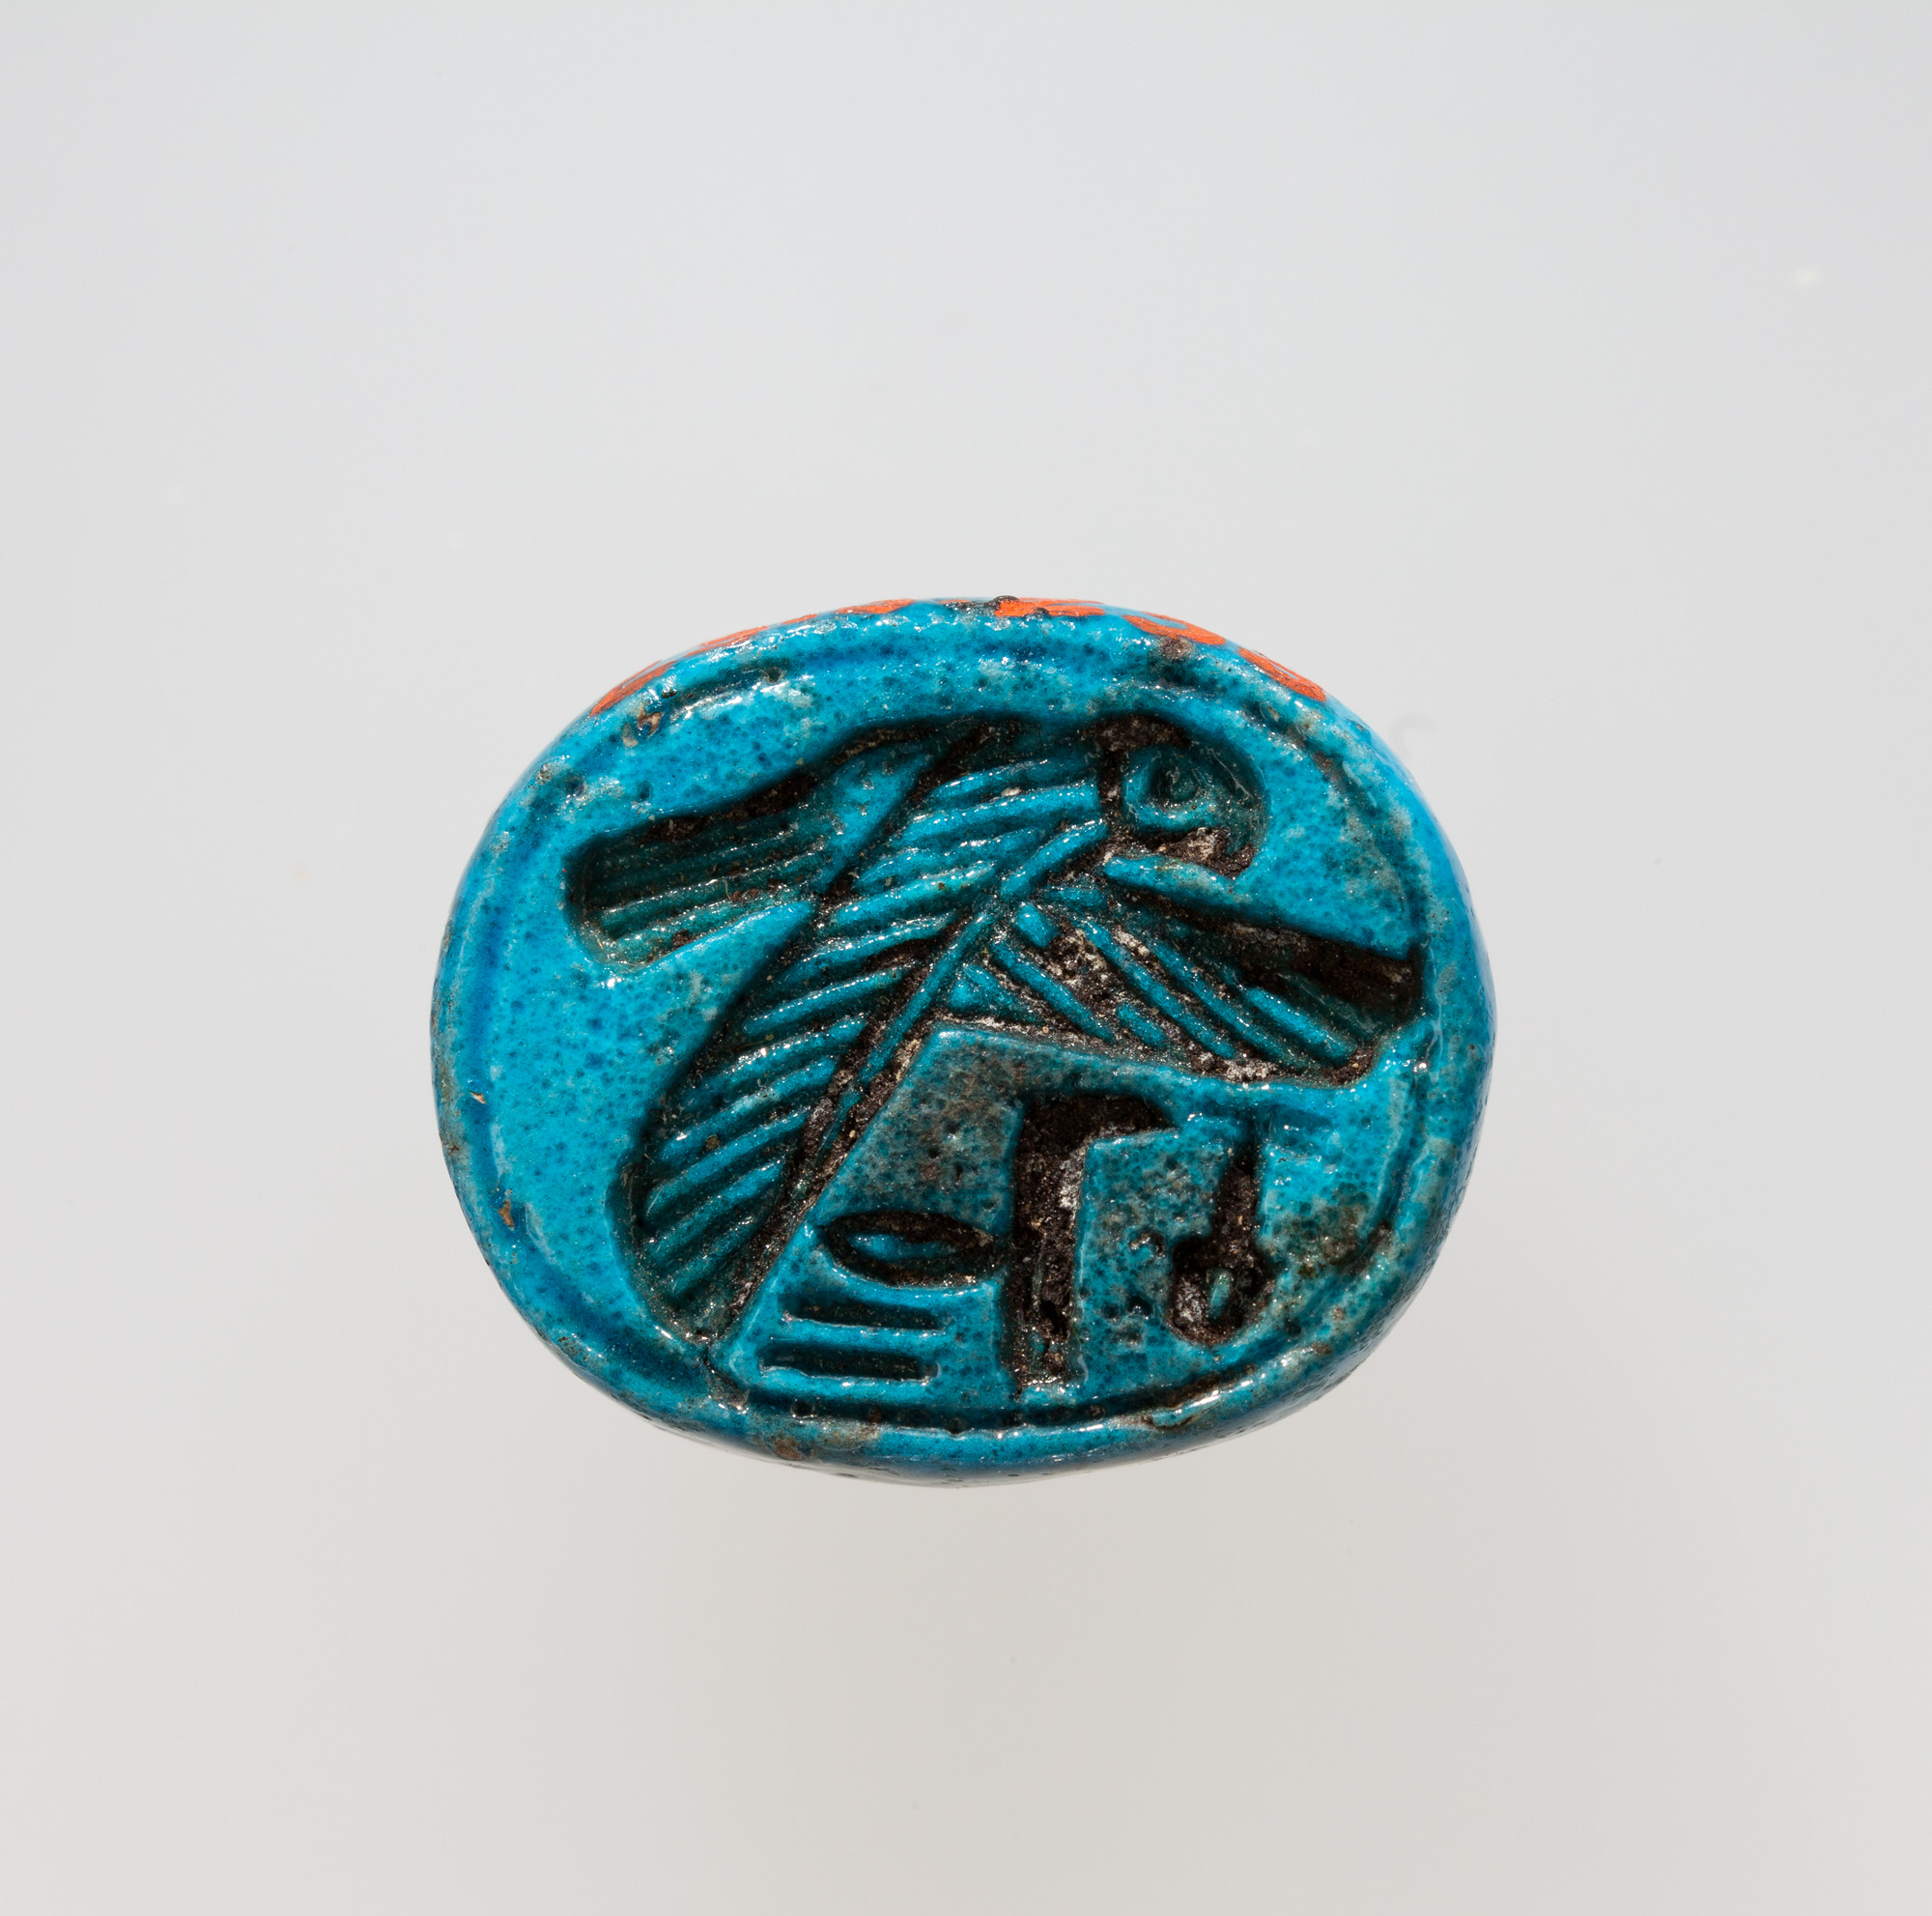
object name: scarab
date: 1479-1458 BCE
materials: faience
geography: egypt